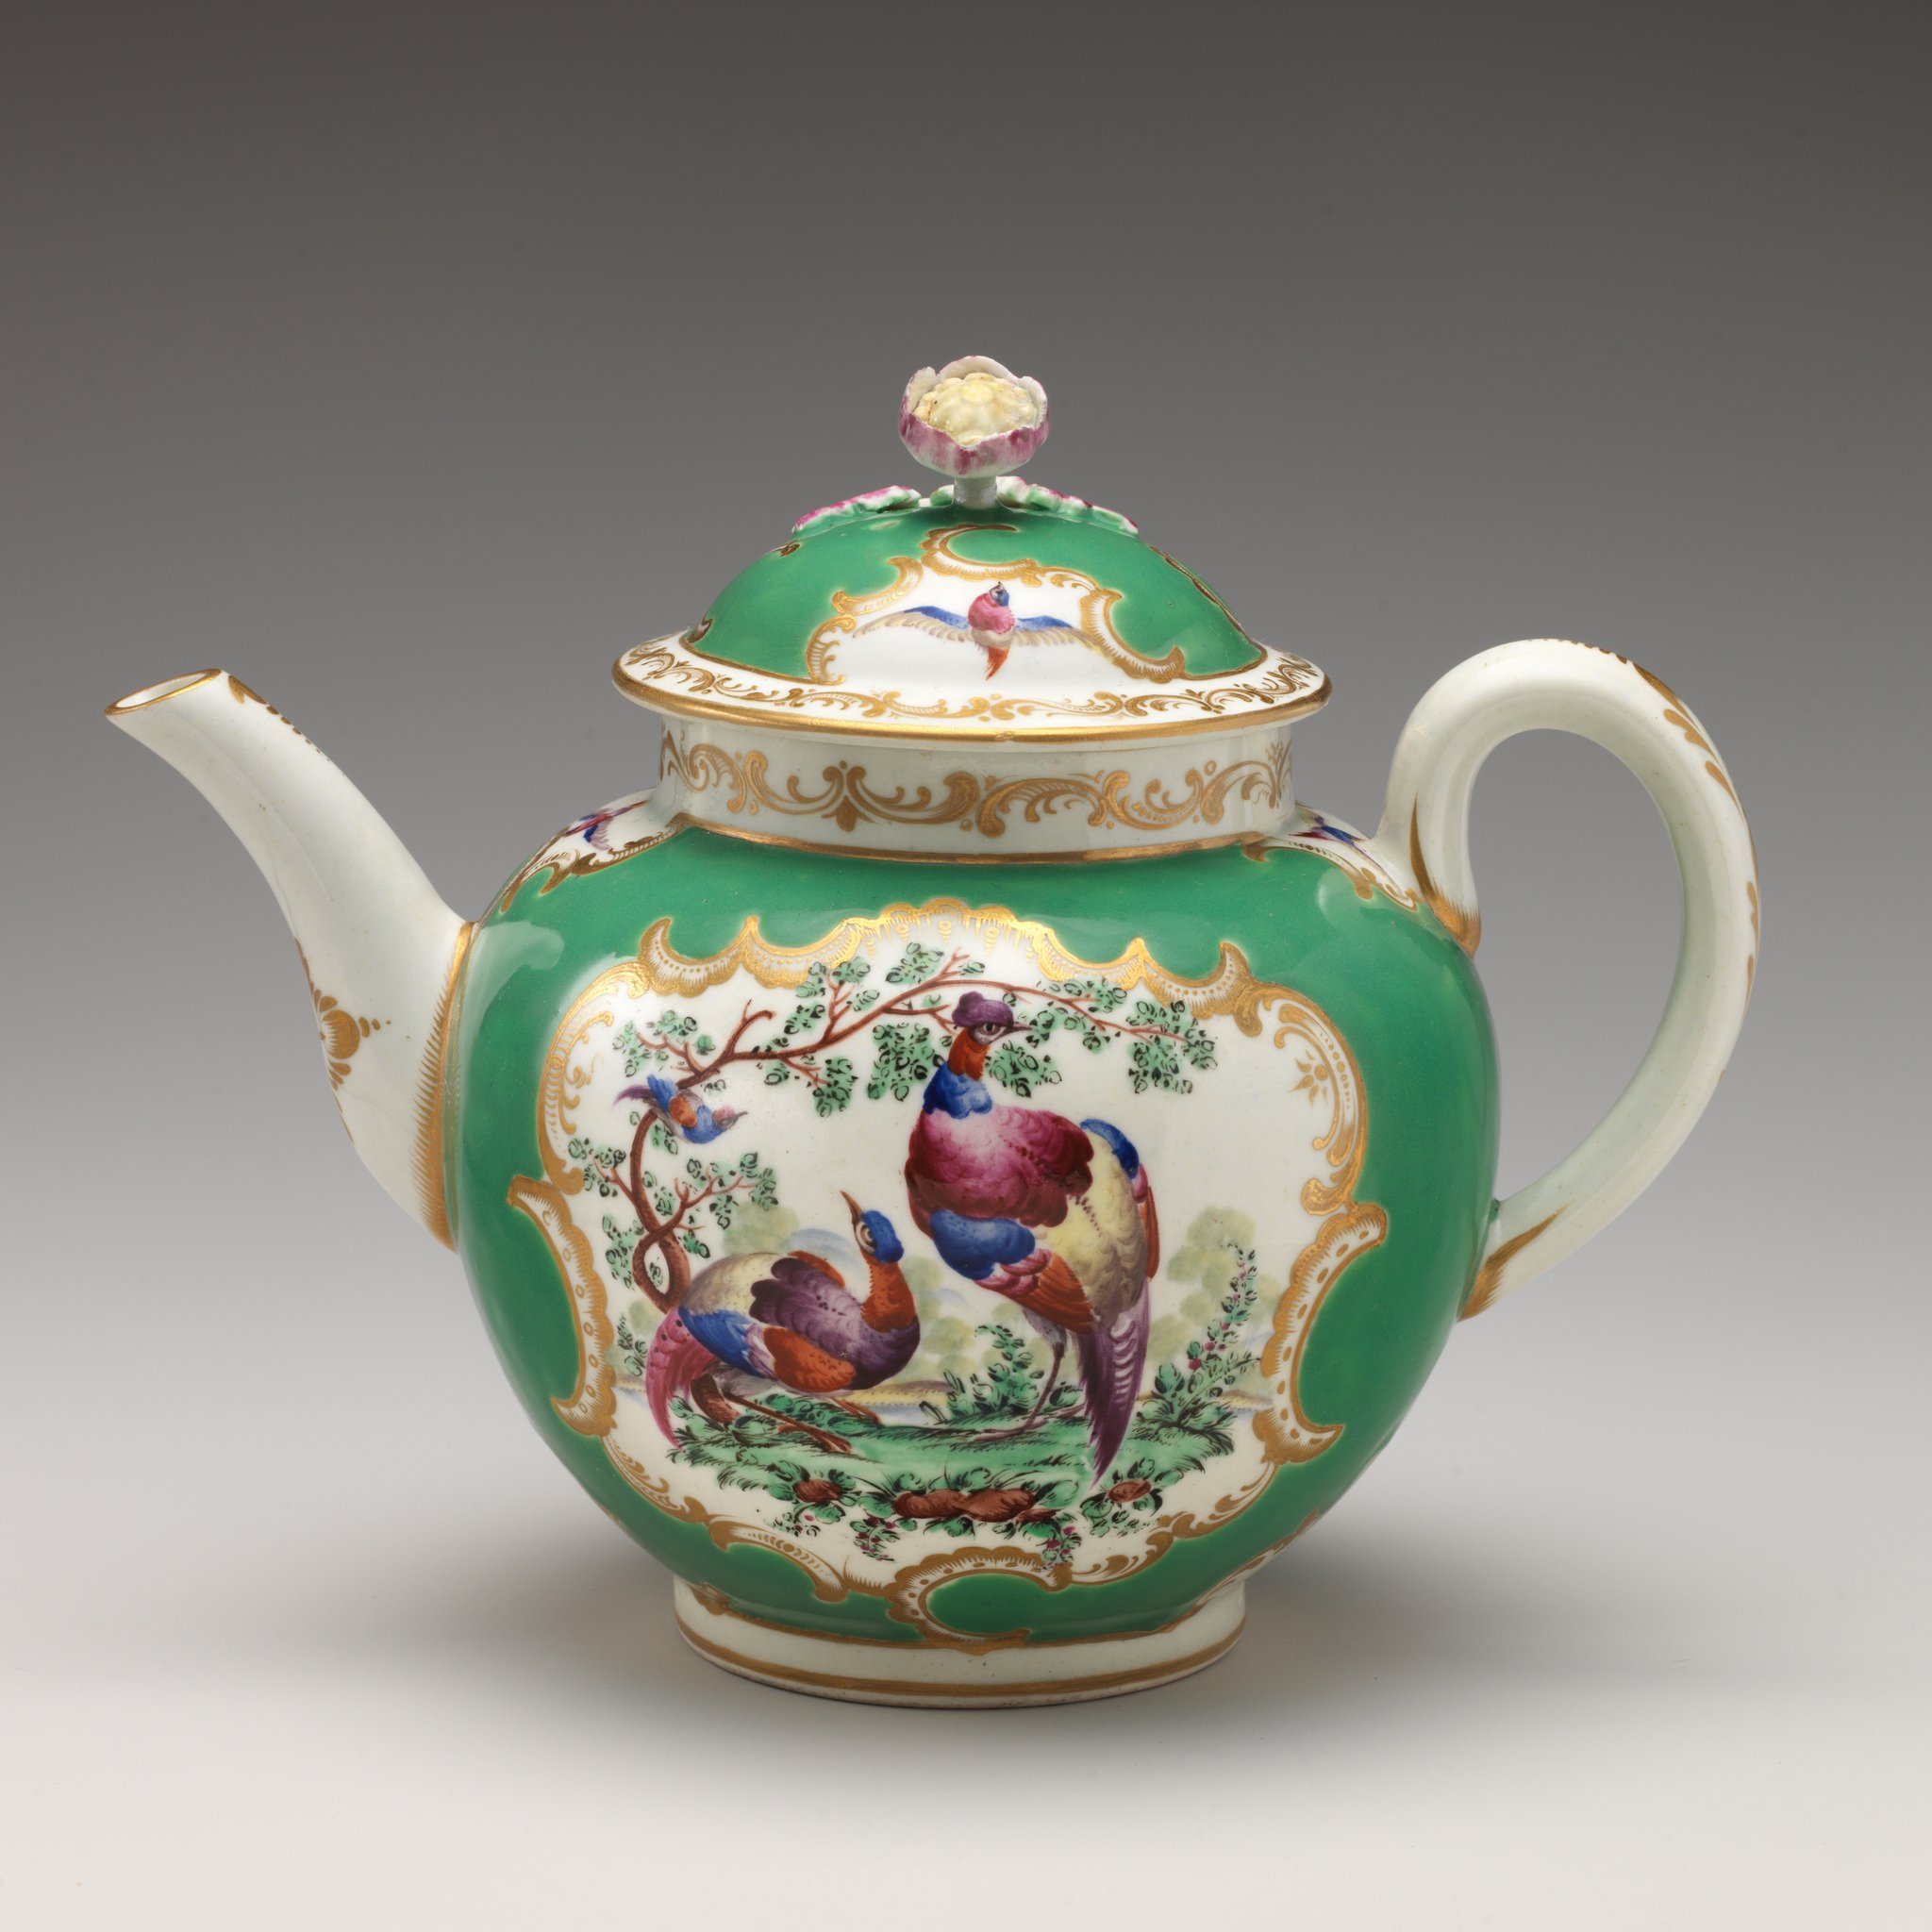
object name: teapot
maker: worcester factory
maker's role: factory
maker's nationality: british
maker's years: 1751-2008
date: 1770-1775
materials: enamel, soft paste porcelain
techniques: gilding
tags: birds